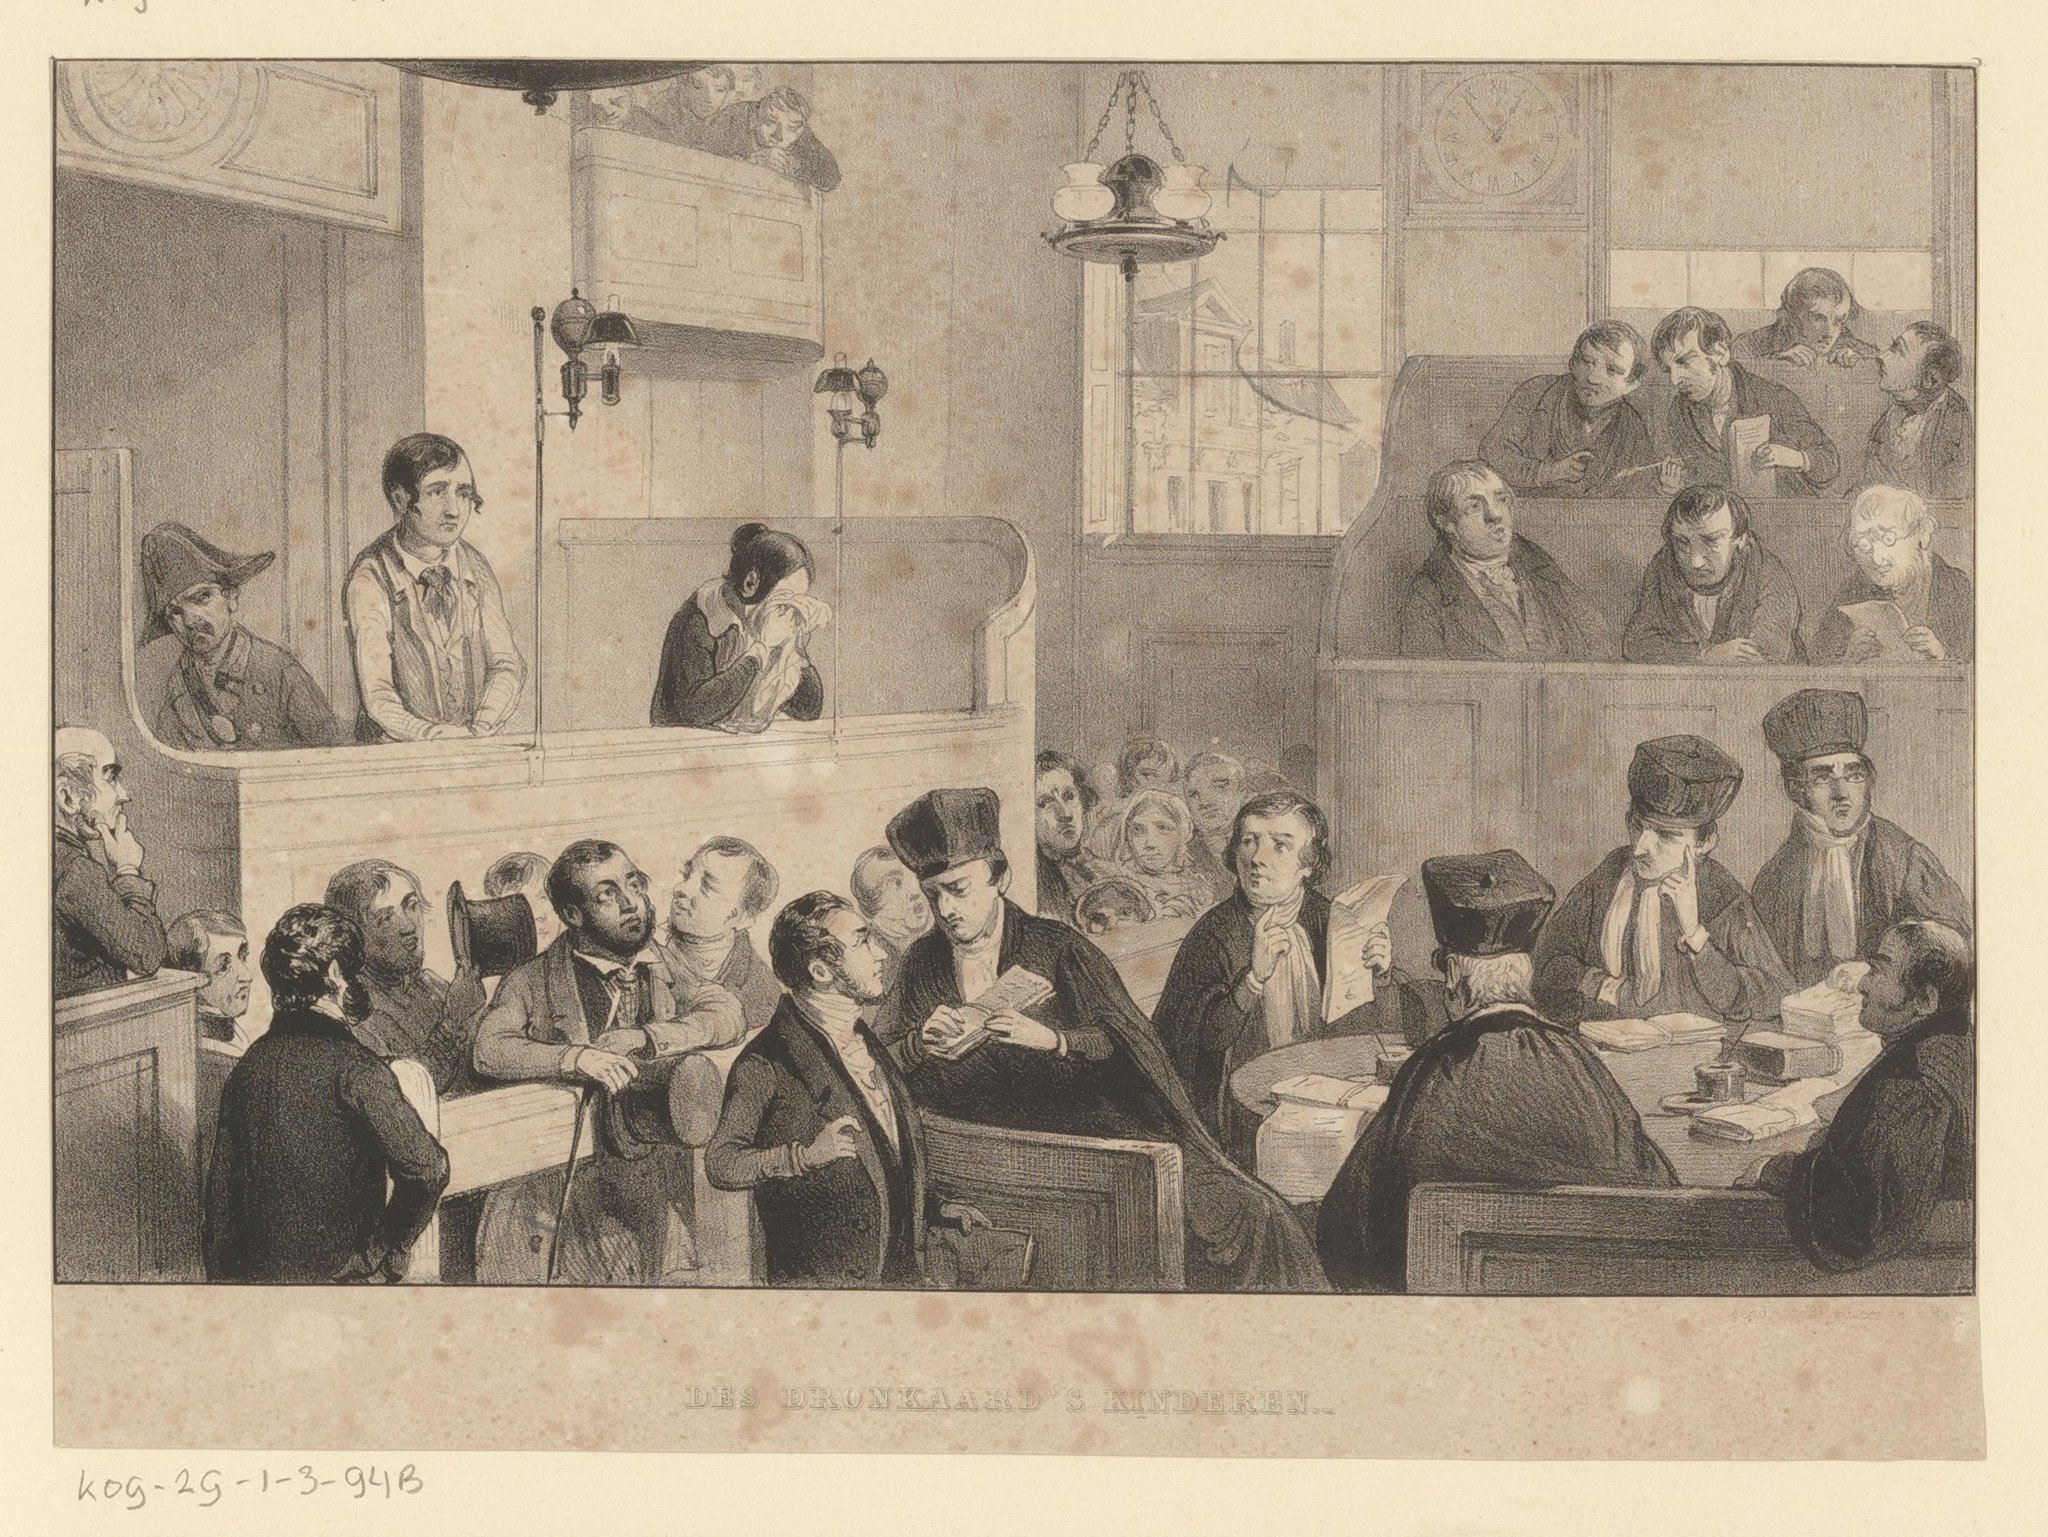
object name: print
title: Des dronkaard's kinderen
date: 1848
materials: paper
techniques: lithograph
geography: the hague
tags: drunkard, court-room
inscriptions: collector's mark: Lugt 1641, stamp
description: Man wordt veroordeeld in een rechtszaal. Naast hem zijn huilende zus. Naar een prentserie van George Cruikshank over de gevolgen van overmatig drankgebruik. Onderwerpsrubrieken binnen de Atlas Zeden en Gewoonten: Regeering, Rechtswezen.